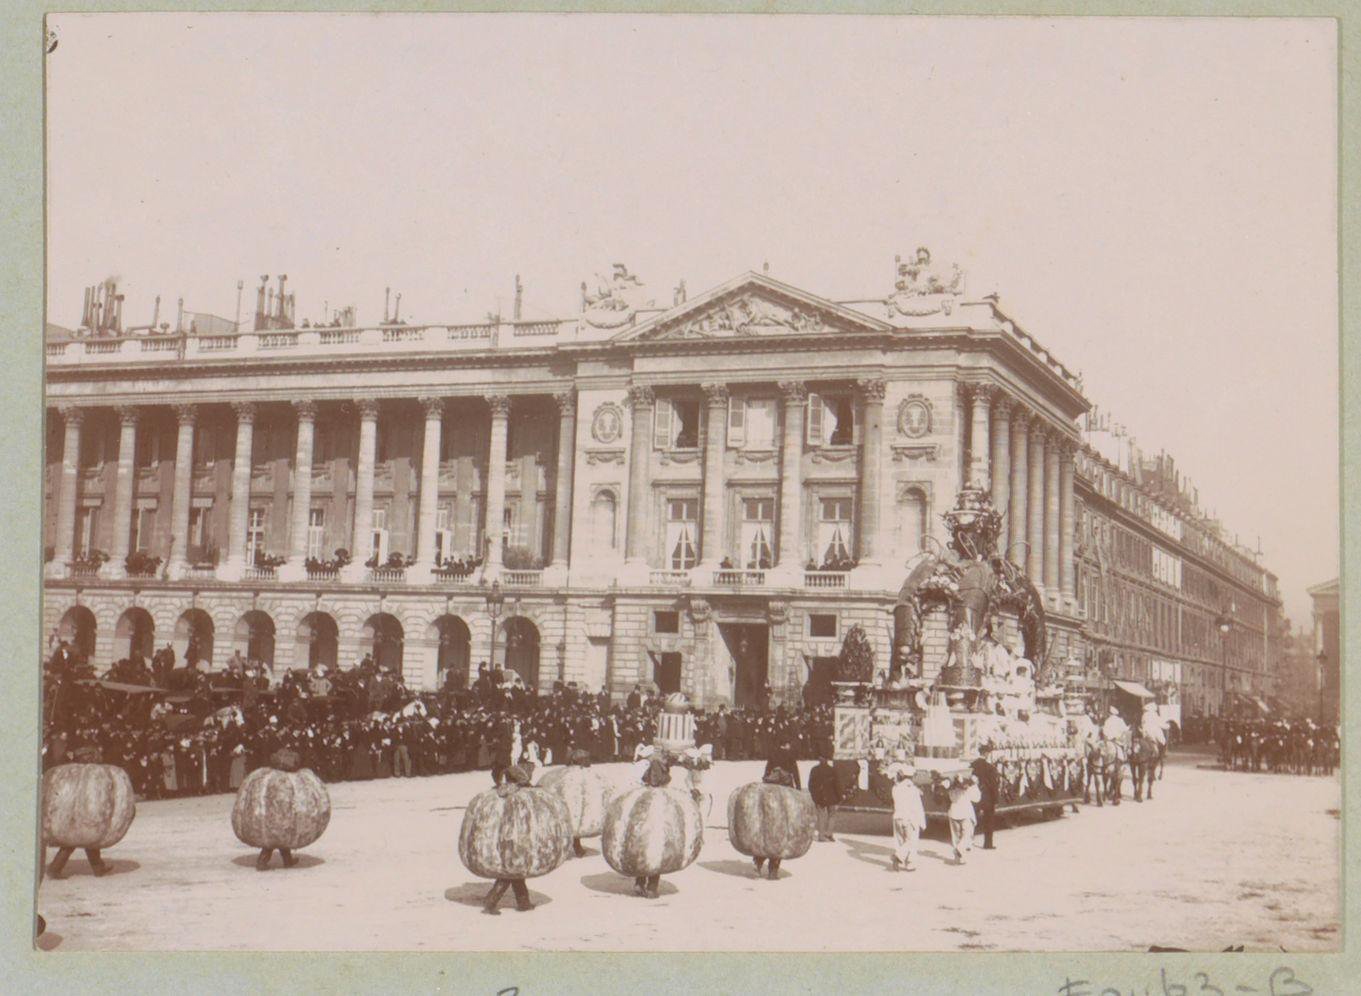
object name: photograph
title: Optocht met praalwagen tijdens Mardi Gras op een plein in Parijs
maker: delizy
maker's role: manufacturer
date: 1896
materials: paper, photographic support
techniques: gelatin silver print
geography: paris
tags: crowd, mob, festivities (+ parade, pageant, cavalcade ~ festive activities), carnival, shrovetide (non-liturgical celebration), exterior ~ representation of a building, paris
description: Onderdeel van Fotoalbum van een Franse amateurfotograaf met opnames van uitstapjes in Frankrijk, Spanje, België, Luxemburg en Nederland, de eerste automobielen en autoraces.